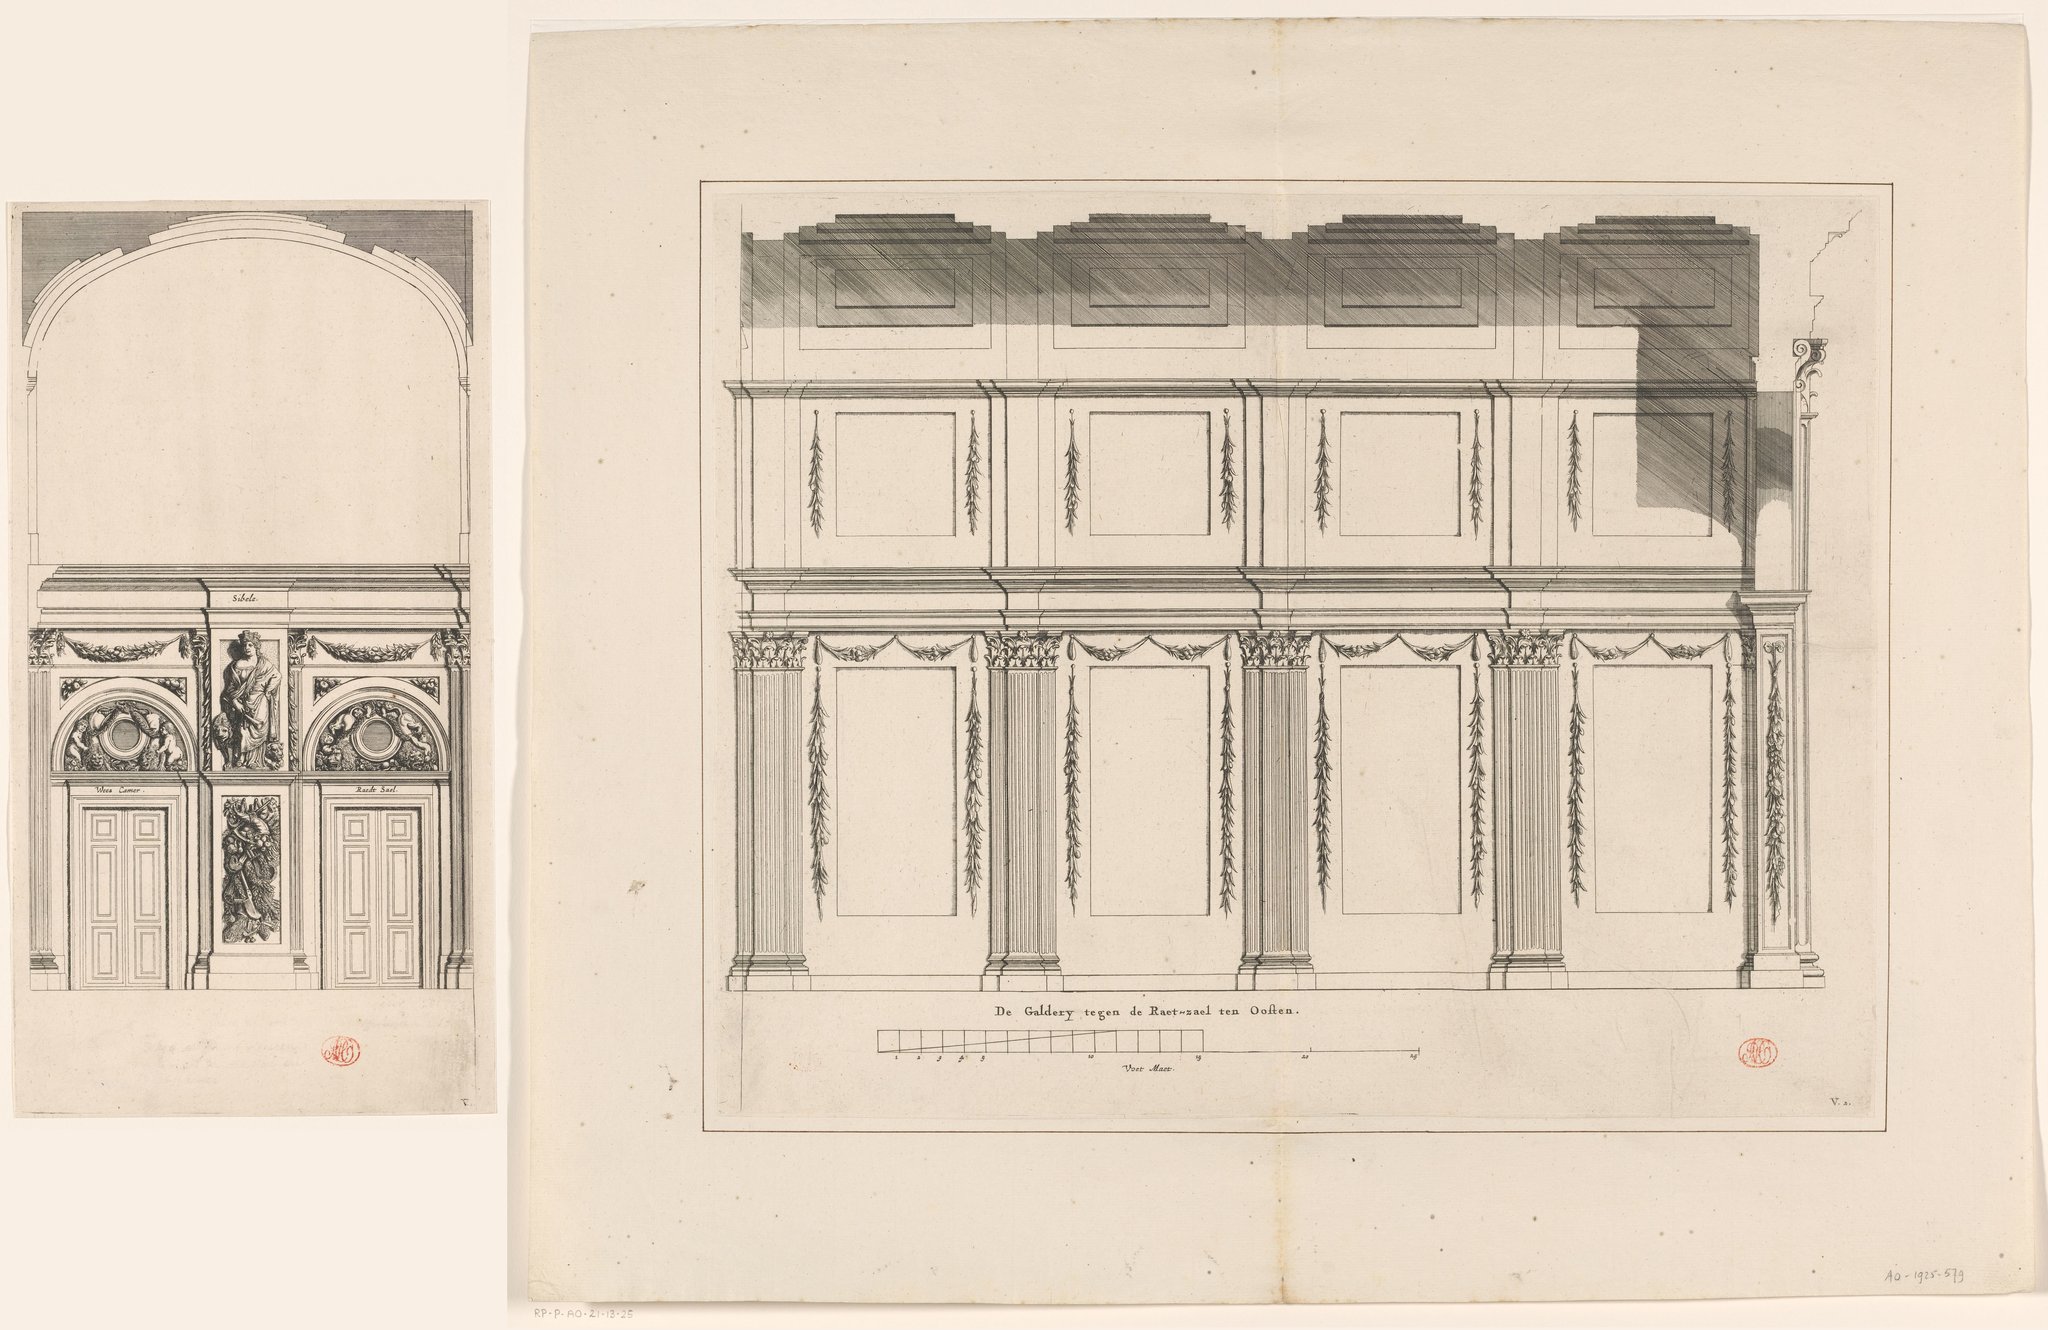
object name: book illustration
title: Noordelijke deel van de oostelijke galerij in het Stadhuis op de Dam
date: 1661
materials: paper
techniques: engraving, etching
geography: amsterdam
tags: (story of) cybele, rhea cybele, great mother of the gods (berecynt(h)ia), interior ~ architectural design or model, townhall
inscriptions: collector's mark: Lugt 195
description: Het noordelijke deel van de oostelijke galerij in het Stadhuis op de Dam te Amsterdam. Links het beeld van Cybele met links daarvan de deur naar de Weeskamer en rechts de deur naar de Vroedschapskamer. Onder in het midden de titel met daaronder een schaalstok: 25 Voet Maet. Onder links en rechts gemerkt: V. 1. en V. 2.